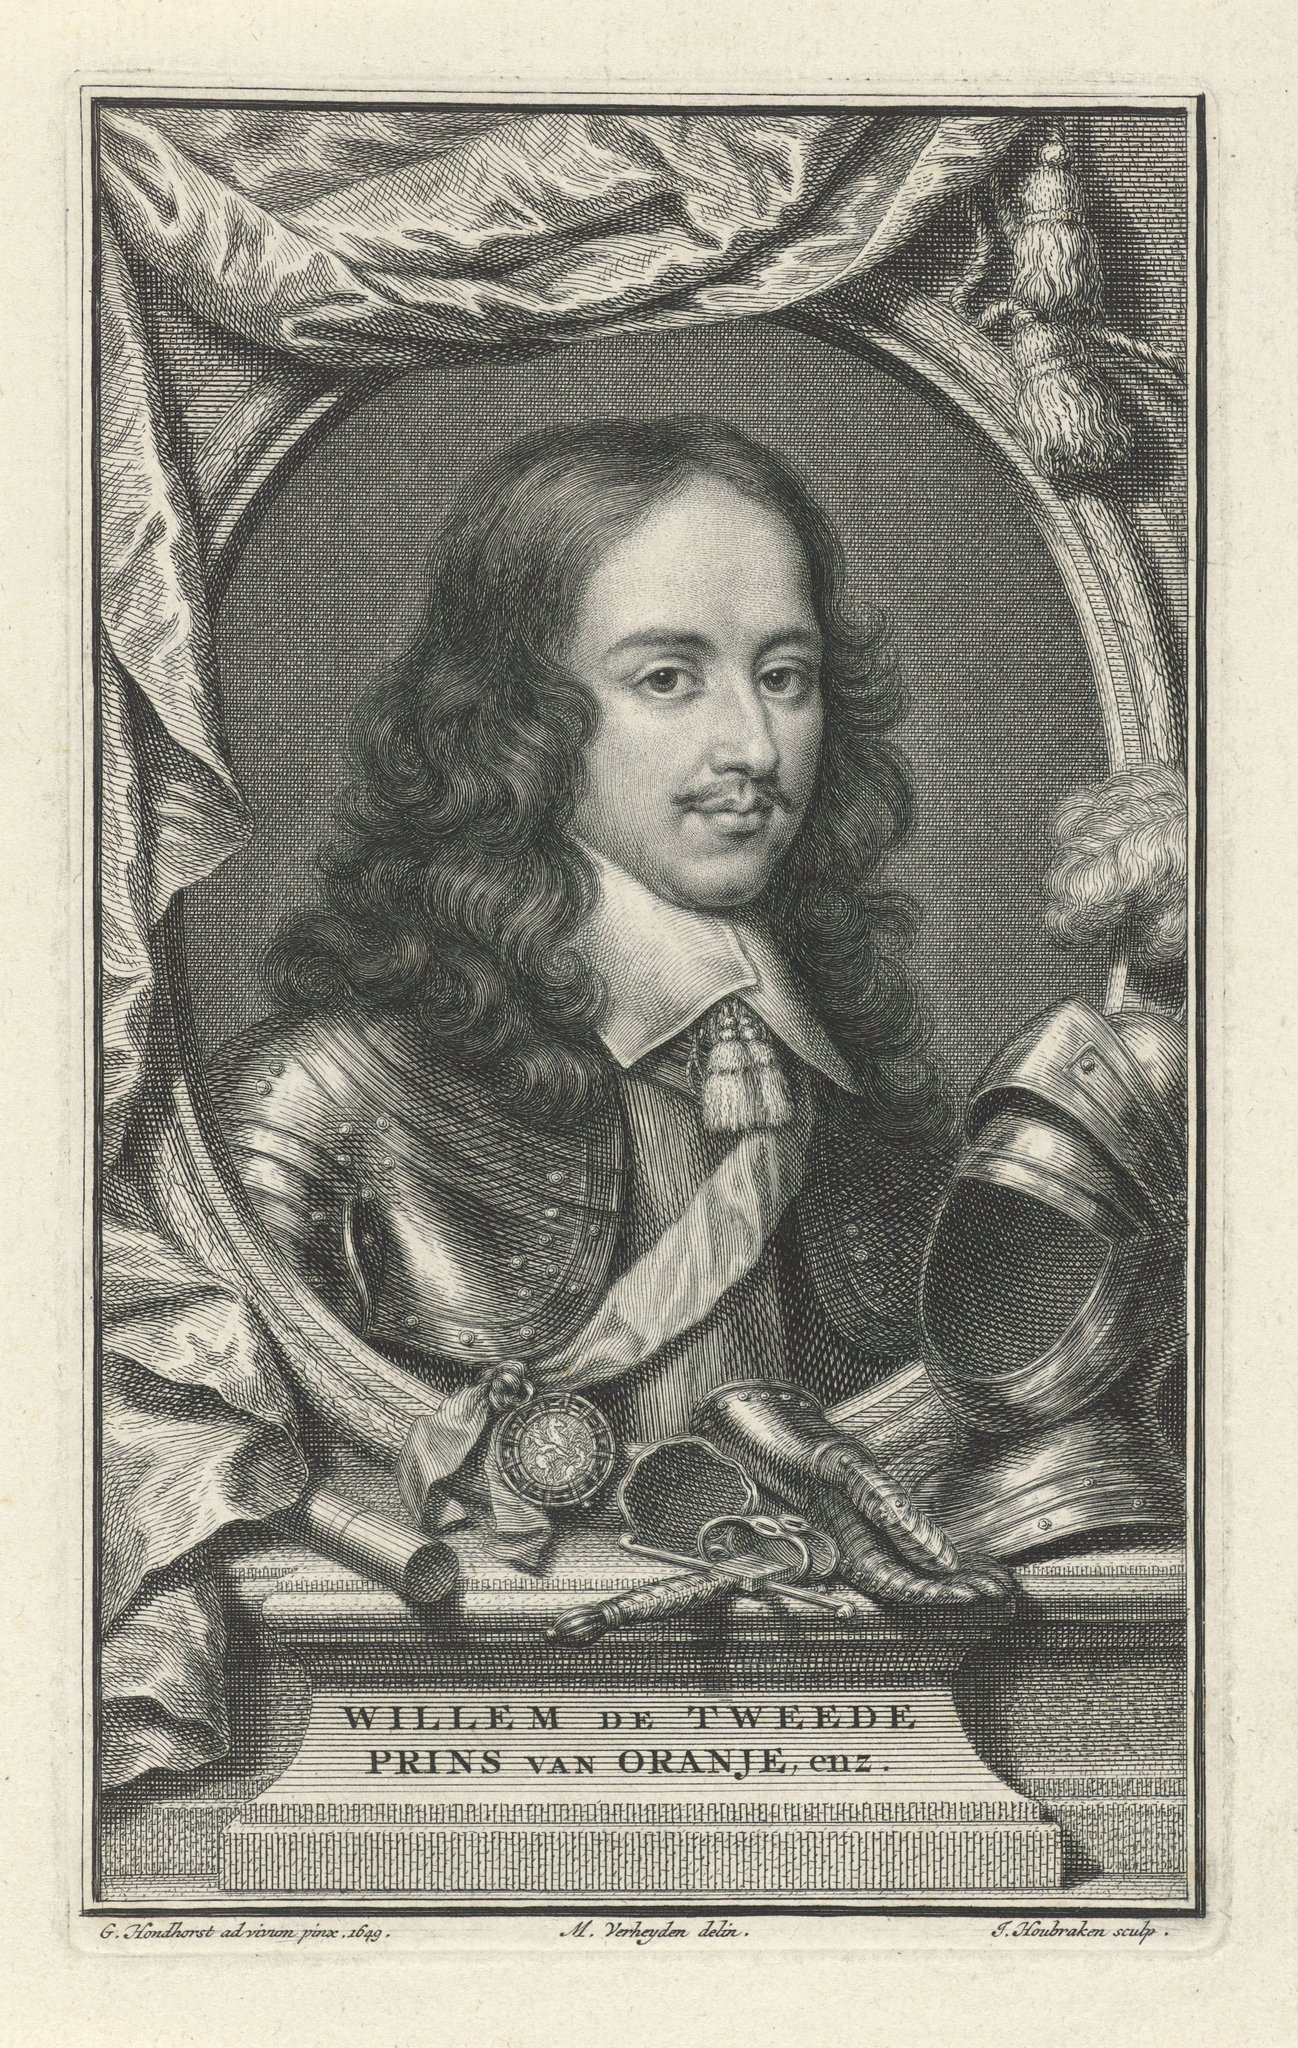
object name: print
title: Portret van Willem II, prins van Oranje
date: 1708-1780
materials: paper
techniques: engraving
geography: amsterdam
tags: william ii (prince of orange)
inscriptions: collector's mark: Lugt 2228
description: Buste naar rechts van Willem II, prins van Oranje, in een ovaal medaillon dat rust op een piëdestal. Links en bovenaan een deel van een gordijn en op de sokkel eveneens een helm, handschoenen, een zwaard en een commandostaf. Op de sokkel zijn naam en titel in twee regels in het Nederlands.